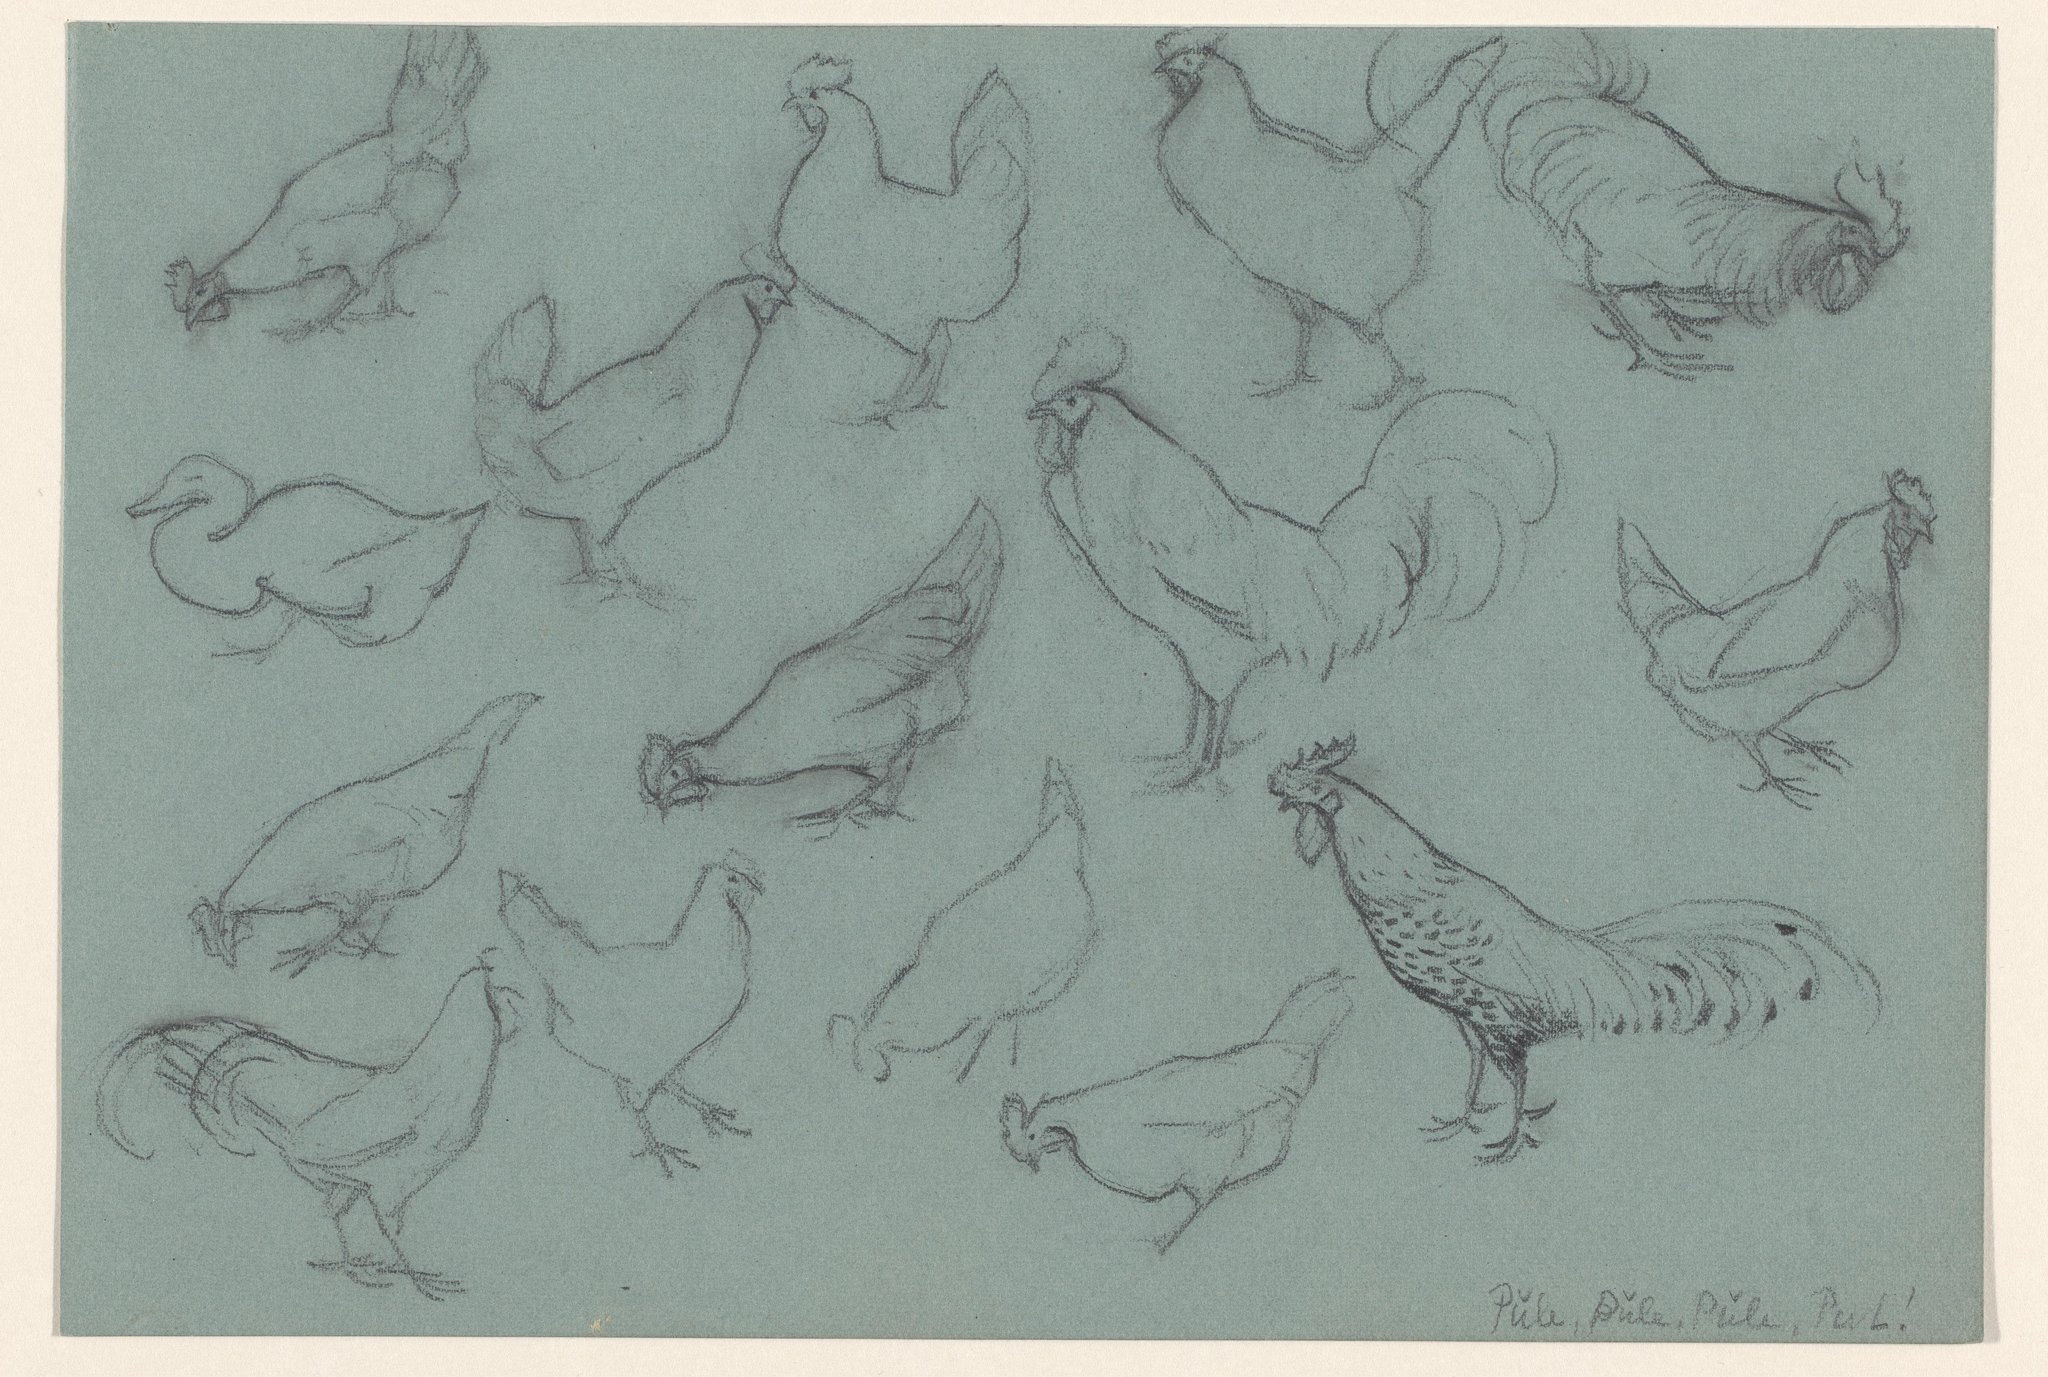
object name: drawing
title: Studieblad met hoenders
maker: julie de graag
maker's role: draughtsman, print maker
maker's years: 1877-1924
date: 1887-1924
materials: paper, pencil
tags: fowl (cock, hen, chicken, etc.)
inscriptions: number: ‘190’, annotation: ‘RP’, annotation: ‘Pûle, Pûle, Pûle, Puh!’